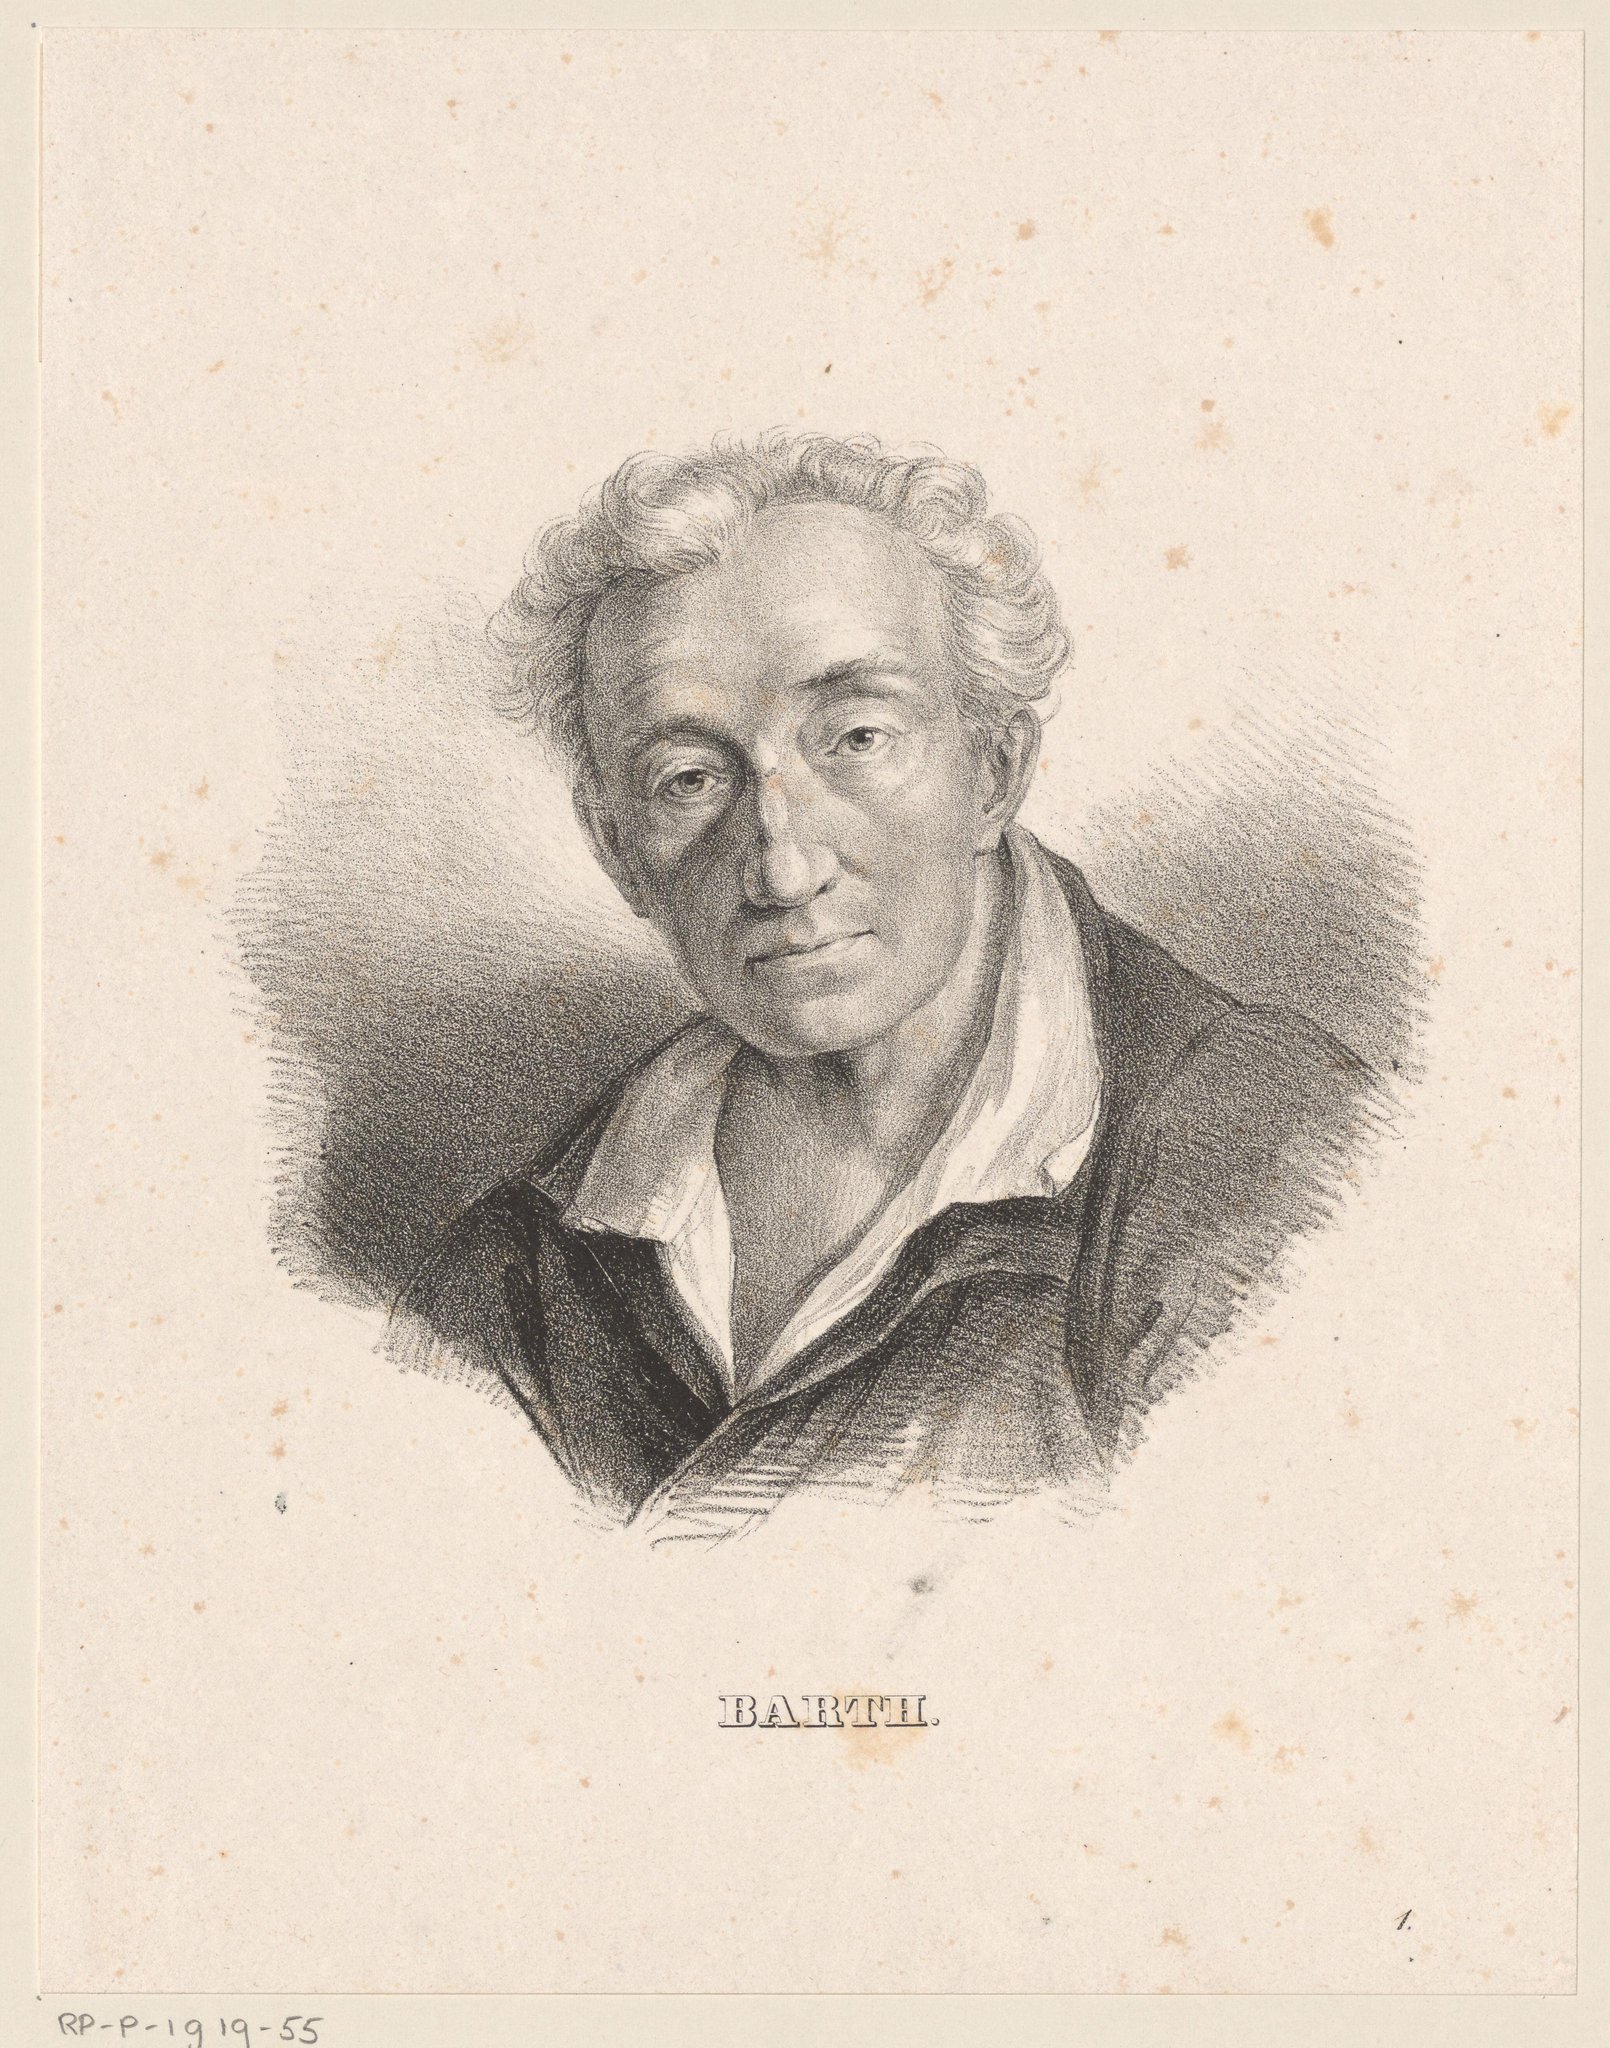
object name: print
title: Portret van Karl Barth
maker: Anonymous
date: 1820-1870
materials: paper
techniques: lithograph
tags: karl barth, historical persons, portrait, self-portrait of artist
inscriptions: collector's mark: Lugt 2228